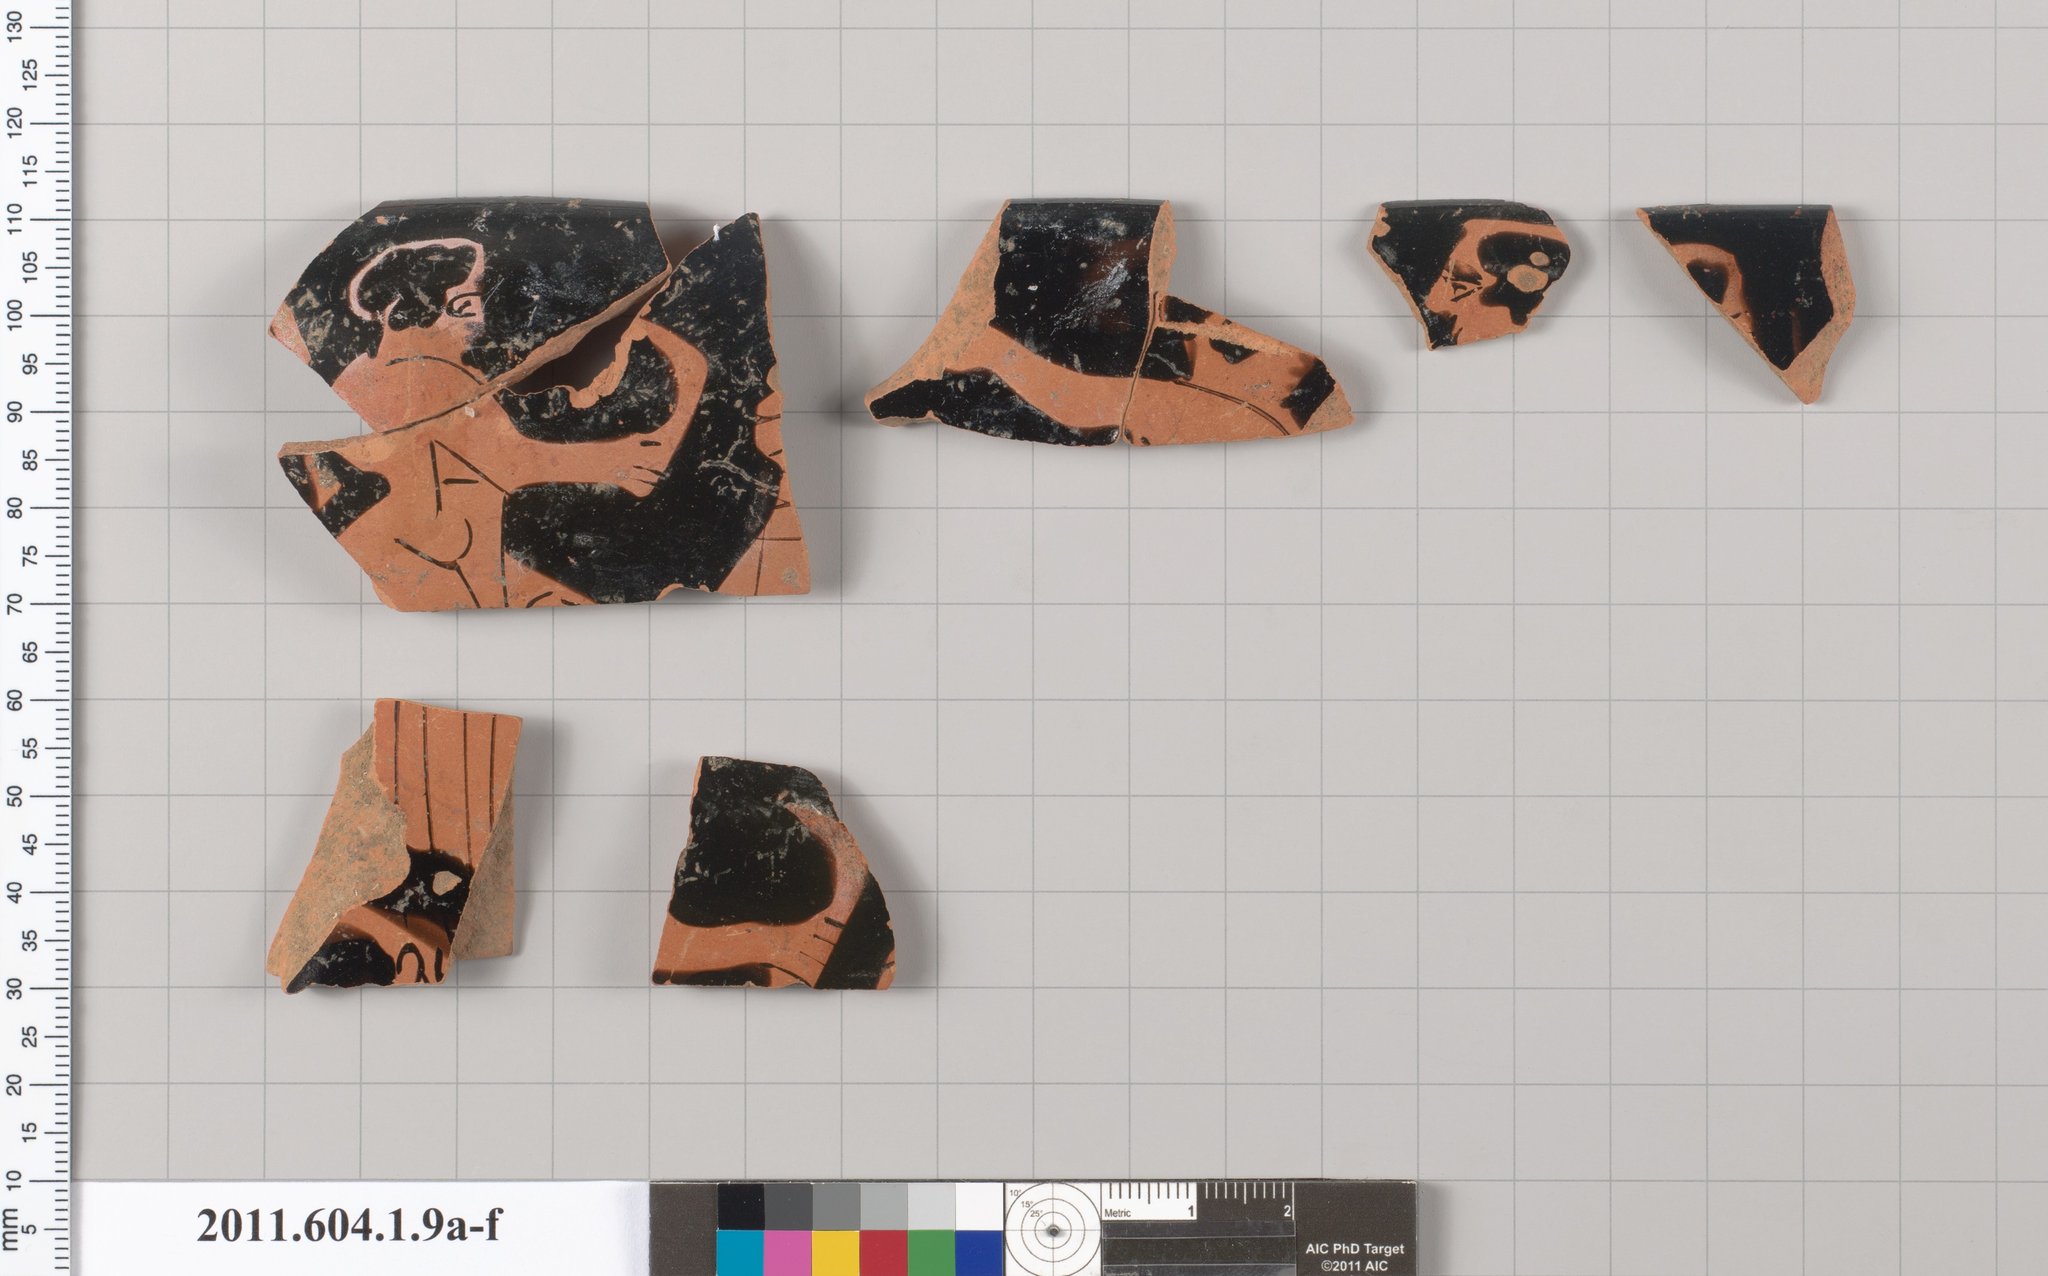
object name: kylix fragment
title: Terracotta fragments of a kylix (drinking cup)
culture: greek, attic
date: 467-435 BCE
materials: terracotta